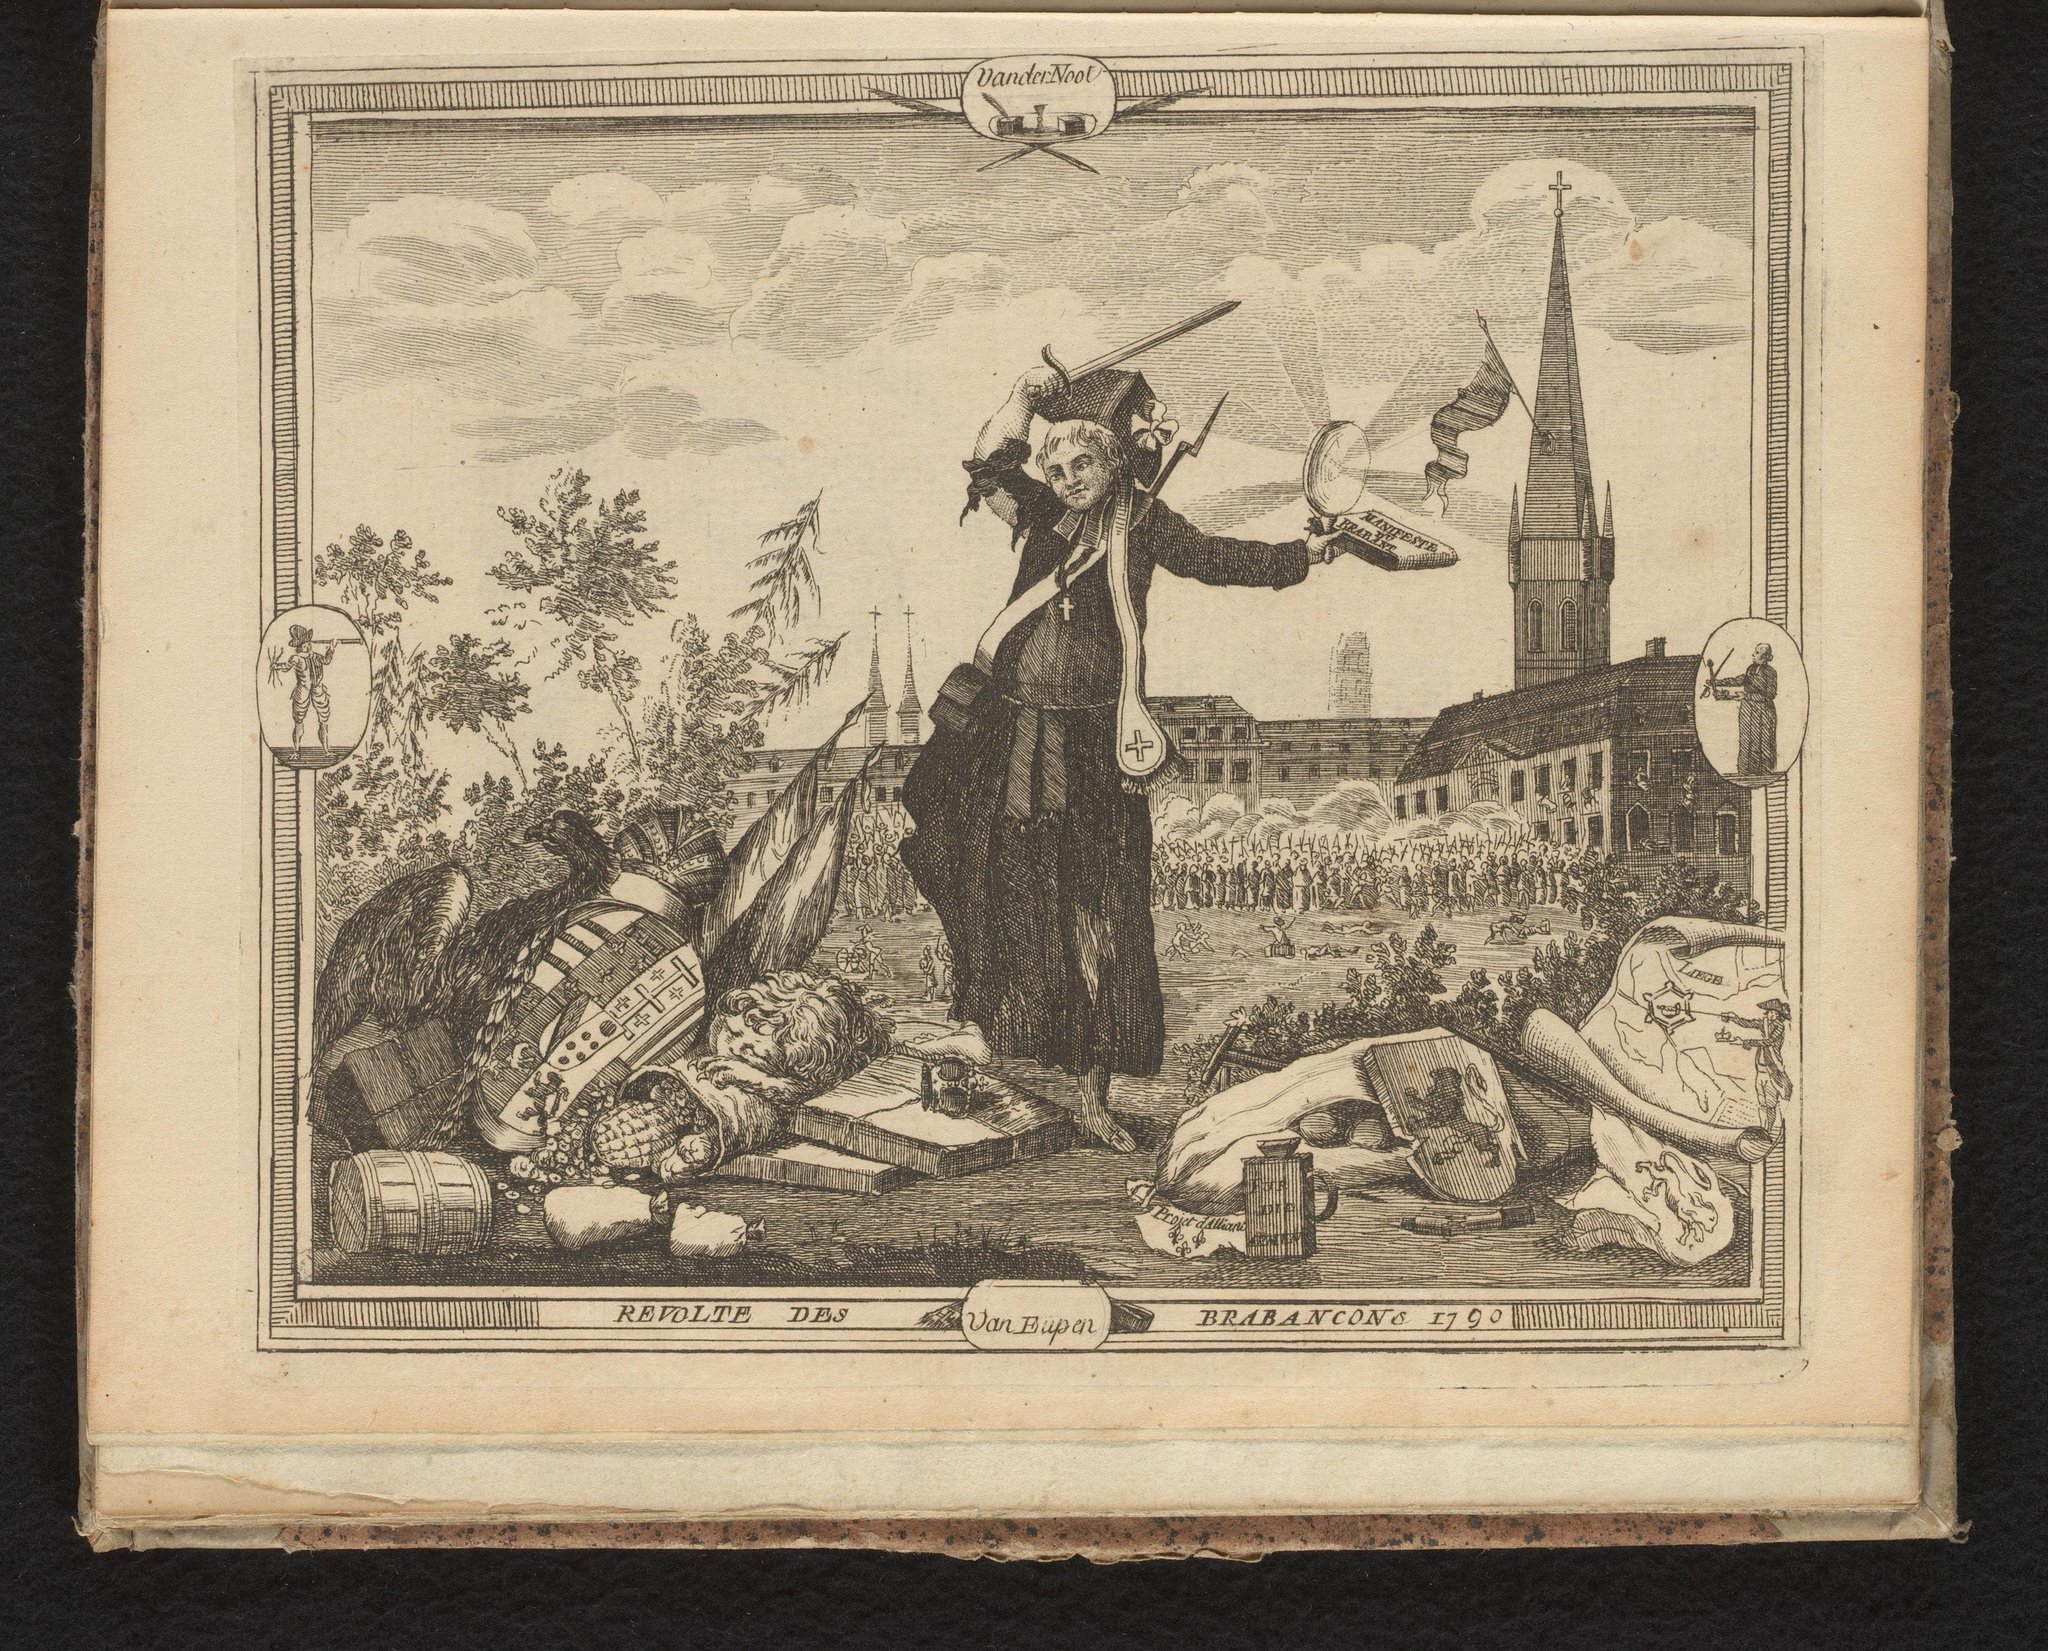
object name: print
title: Allegorie op de Brabantse Omwenteling, 1790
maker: Anonymous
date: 1787-1790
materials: paper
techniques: engraving, etching, letterpress printing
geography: southern netherlands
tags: antwerp, liège, brabant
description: Allegorie op de Brabantse Omwenteling van 1790. Centraal de geestelijke Van Eupen zwaaiend met een zwaard en het Manifest van Brabant en een brandglas. Op de grond liggen het wapen en de adelaar van Oostenrijk, vaandels, de slapende Brabantse Leeuw, het wapen van Brabant en een kaart waarop Luik is aangegeven. Van Eupen vertrapt onder zijn voet de keizerlijke kroon. Op de bladzijde naast de prent staat een uitleg van de voorstelling. Onderdeel van de gebundelde verzameling prenten betrekking hebbend op de gebeurtenissen van de Brabantse Omwenteling en de periode 1787-1790.